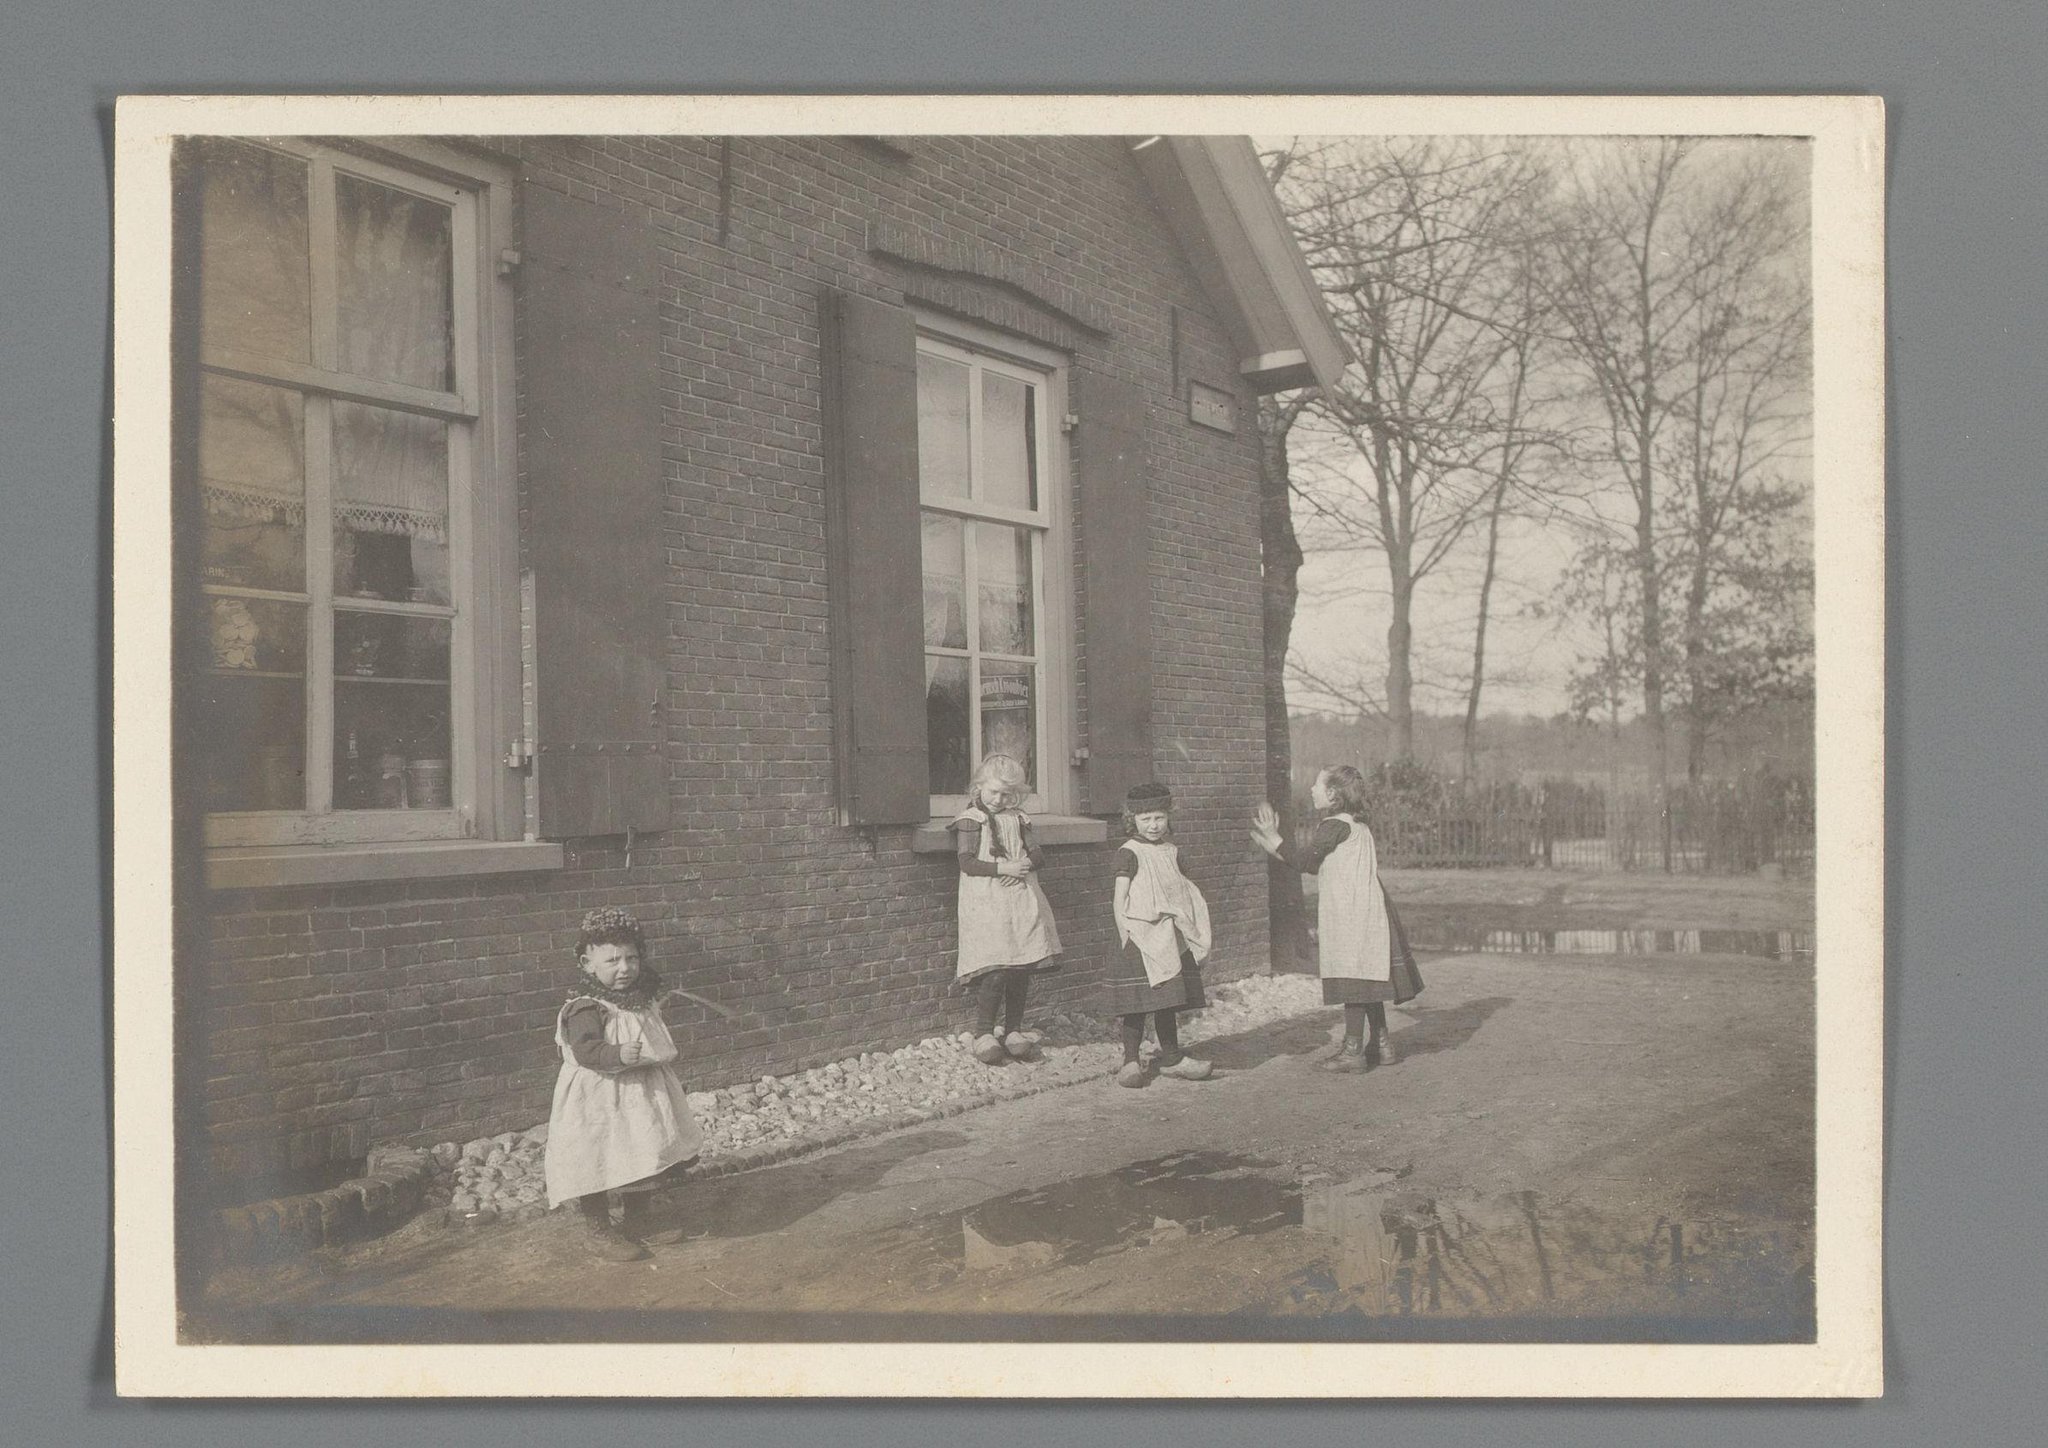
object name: photograph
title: Vier jonge meisjes bij een boerderij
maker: willem de jong (fotograaf)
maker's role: arts, fotograaf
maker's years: 1864-1918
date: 1895-1918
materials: paper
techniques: gelatin silver print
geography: netherlands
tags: girl (child between toddler and youth), farm (building)